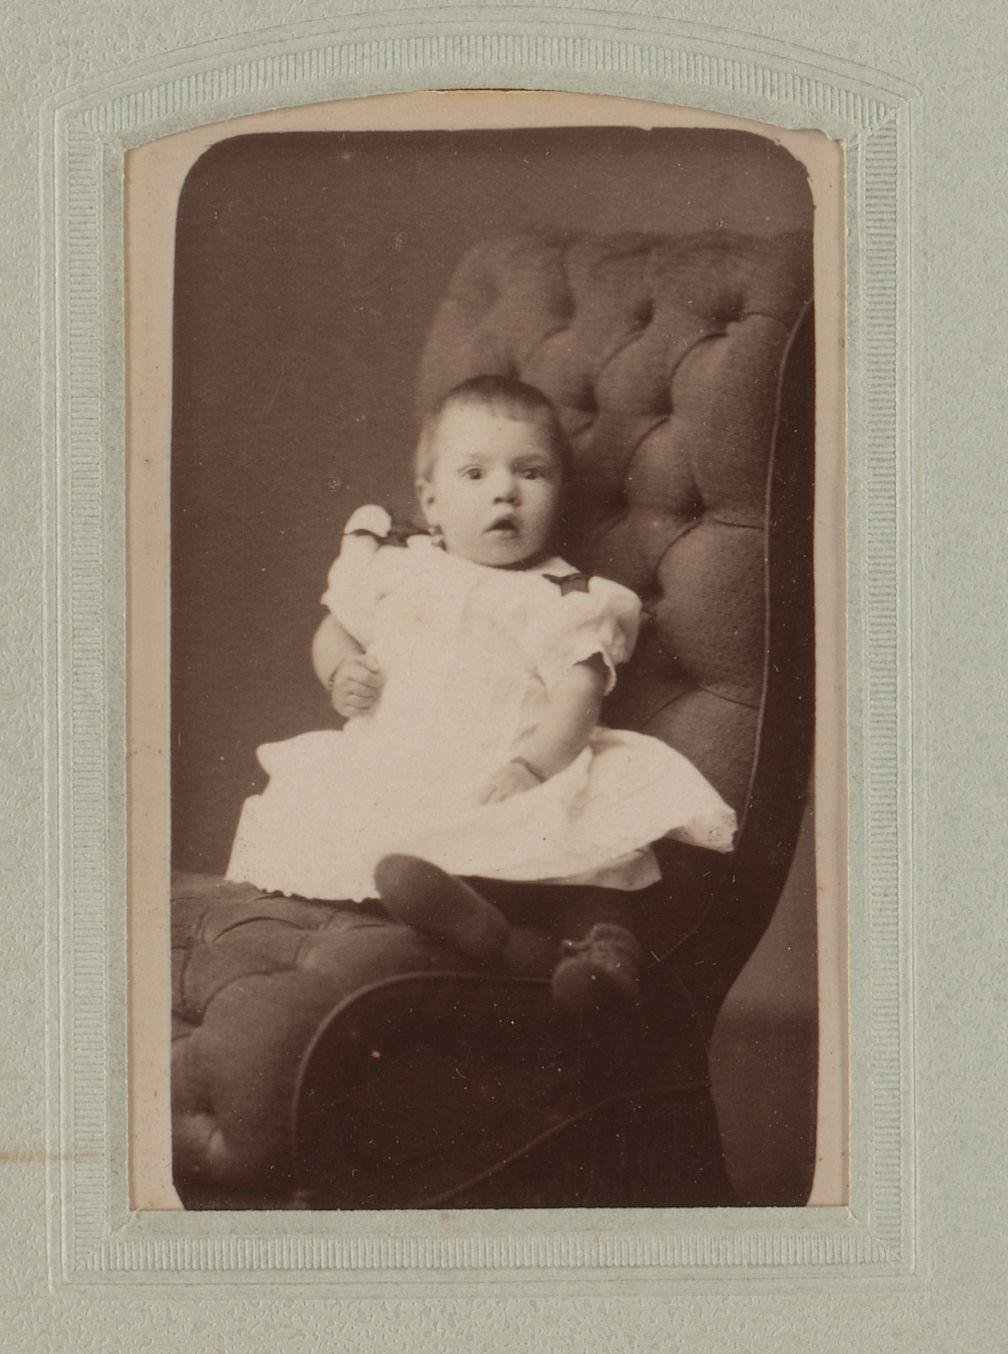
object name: album leaf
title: Portret van een baby op een stoel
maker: willem gerhardus kuijer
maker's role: fotograaf, hoffotograaf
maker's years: 1834-1899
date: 1890-1910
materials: cardboard, celluloid, photographic support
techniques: albumen print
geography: amsterdam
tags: historical persons, infant, baby